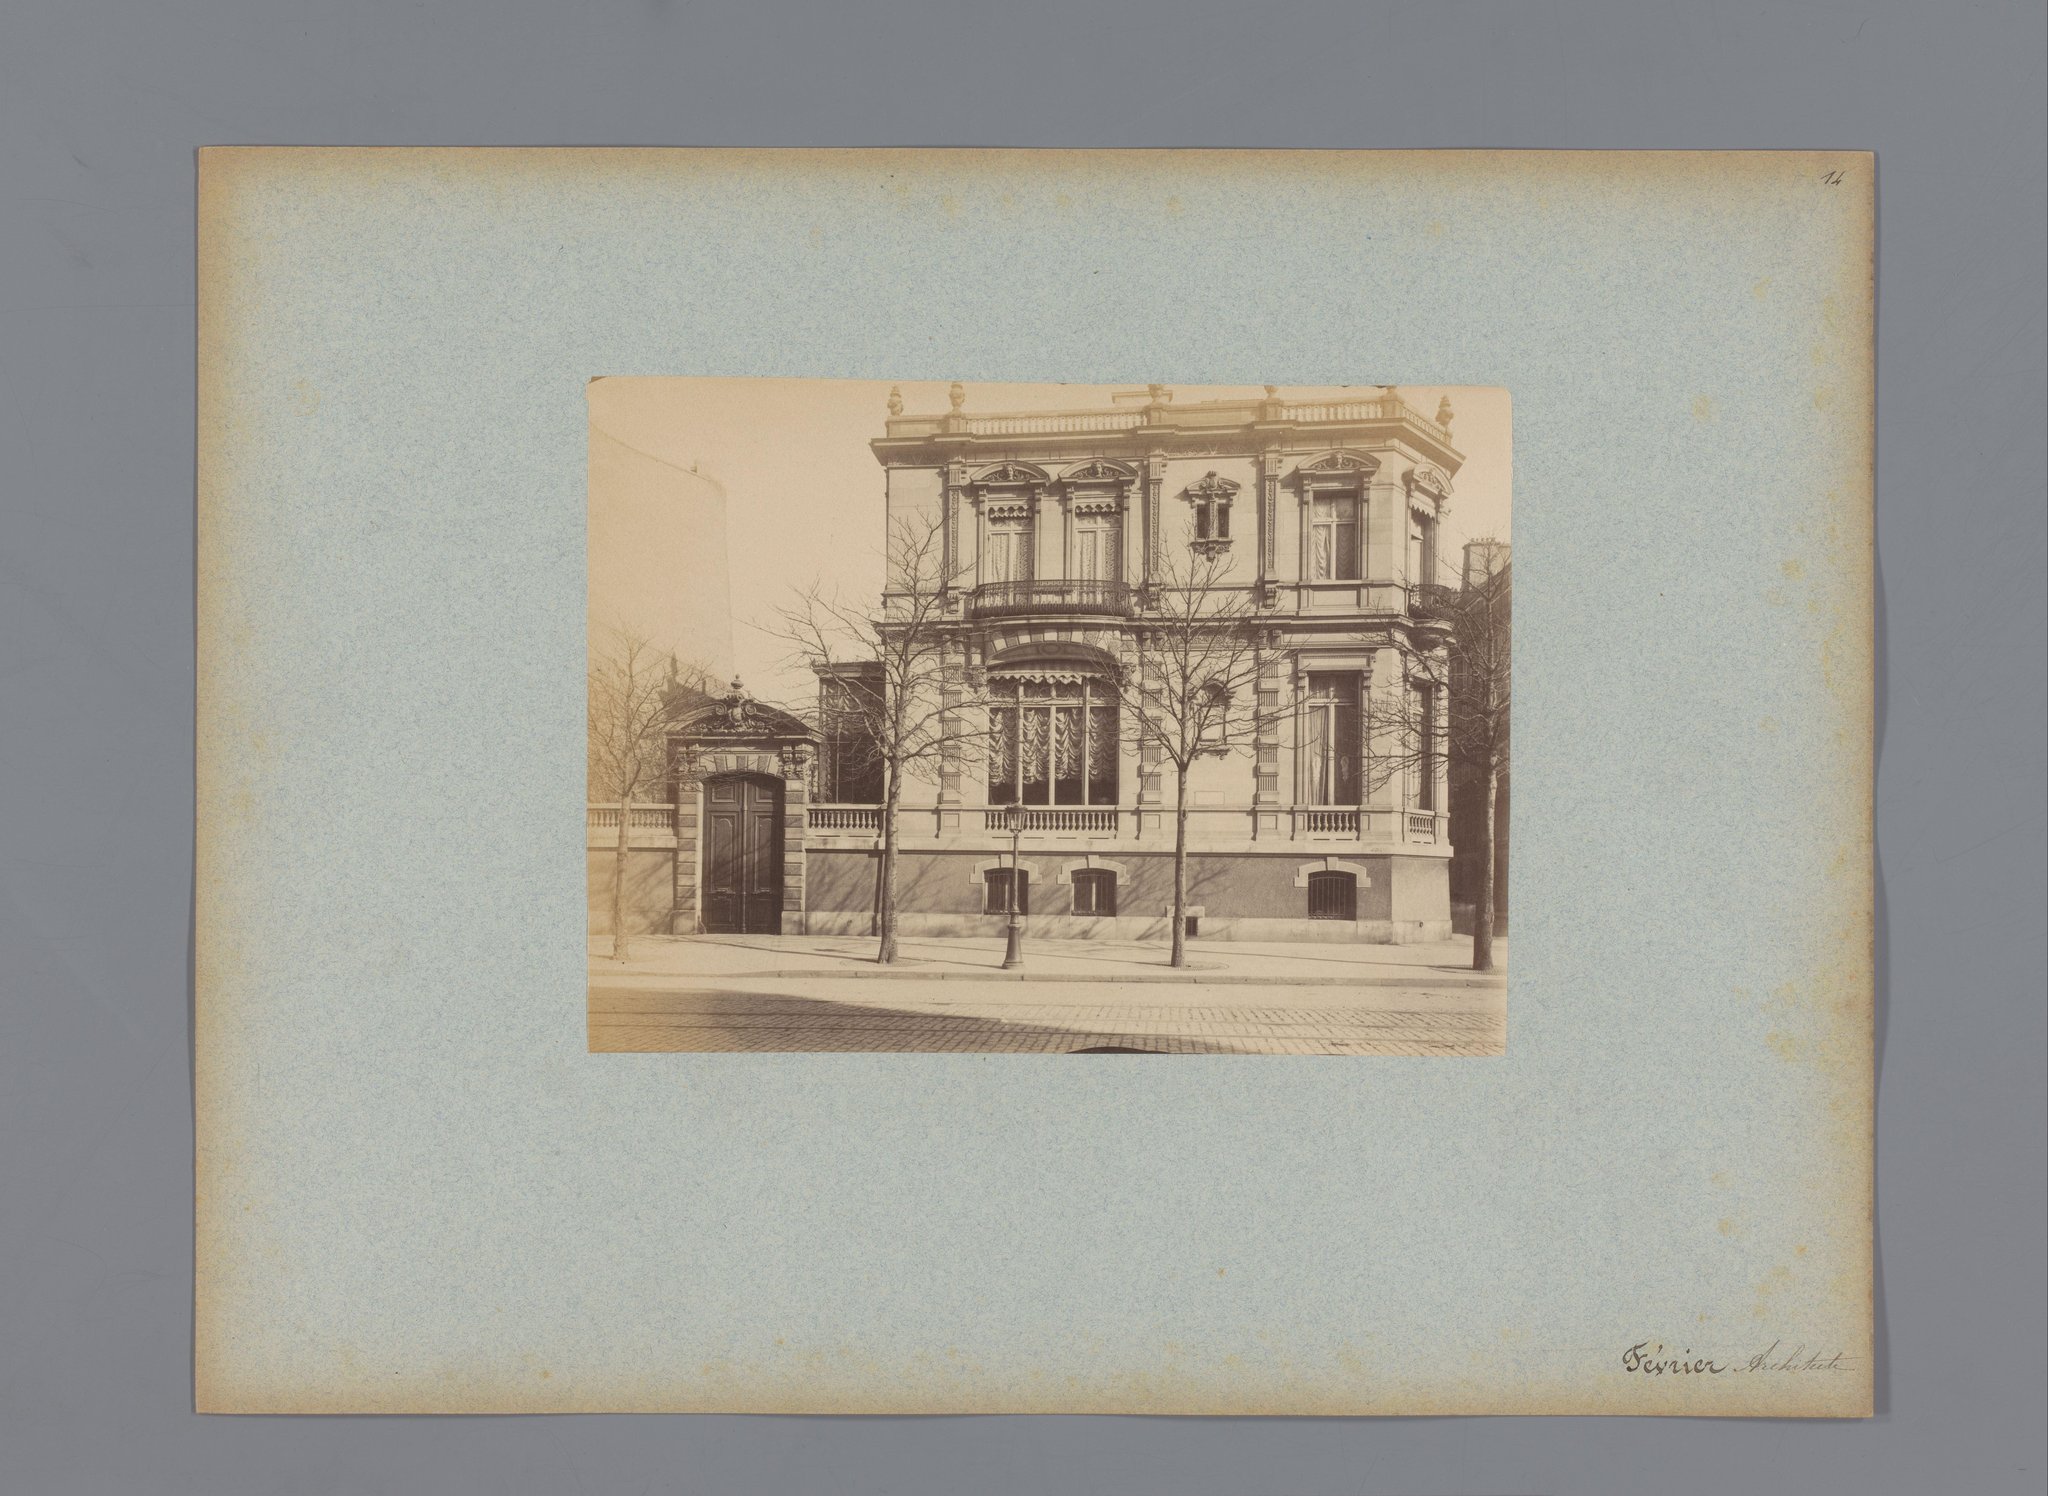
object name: photograph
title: Façade van een villa in Parijs, ontworpen door Jules Février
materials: photographic support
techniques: albumen print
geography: paris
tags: detached house in city, façade (of house or building), paris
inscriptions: name: ‘Février Architecte’, number: ‘14’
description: Deze foto maakt deel uit van een omslag met 35 foto's en een titelblad.